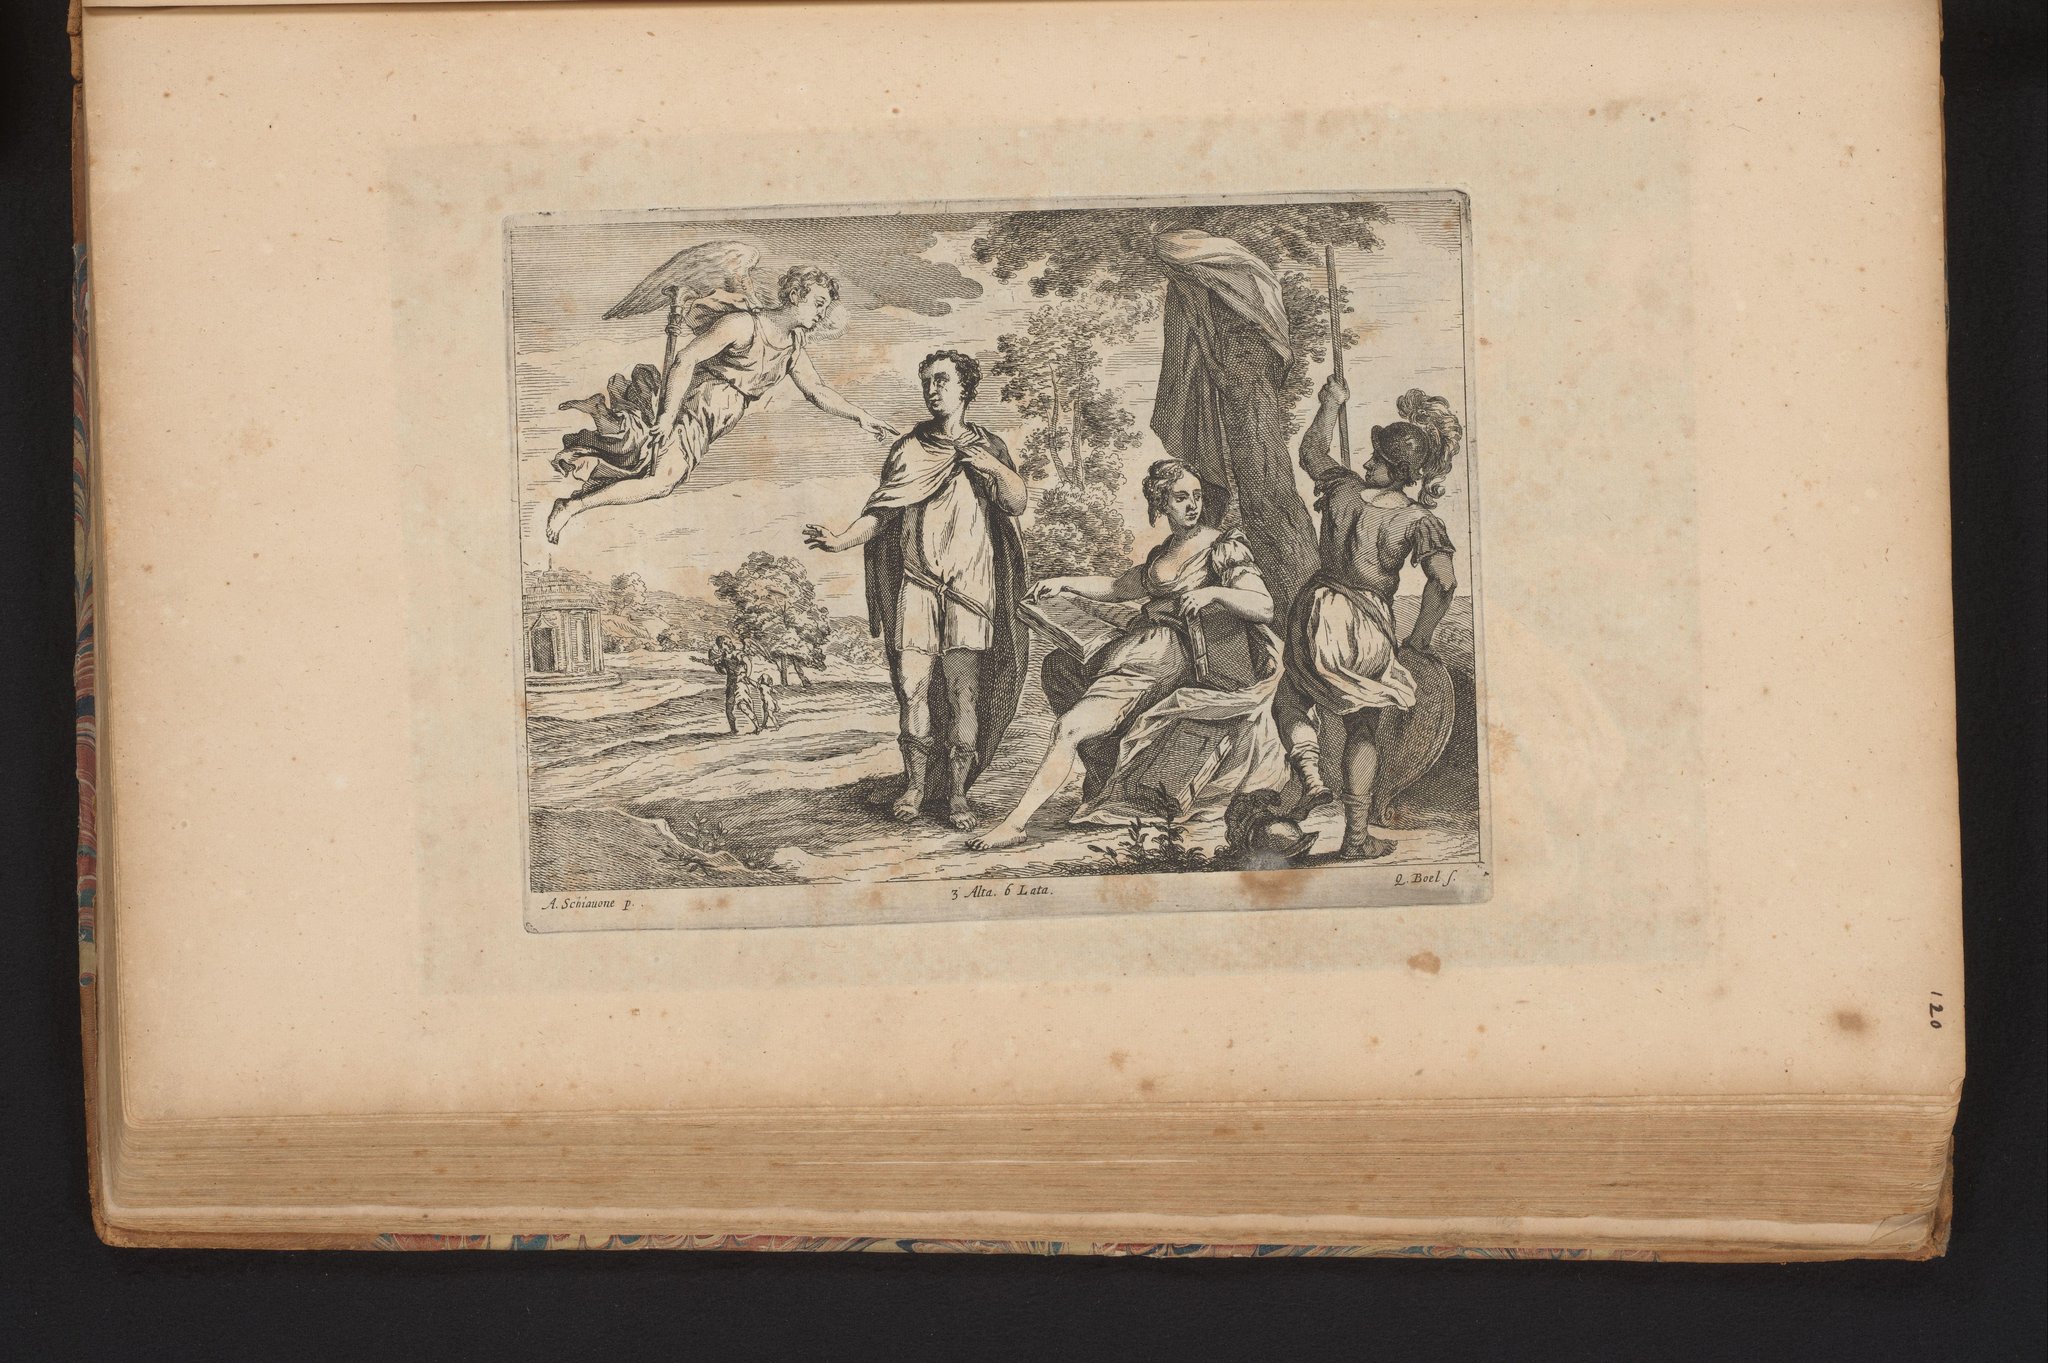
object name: print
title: Aeneas wordt weggeroepen van Dido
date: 1660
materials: paper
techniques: etching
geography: italy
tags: mercury summons aeneas, engaged in building activities, to leave carthage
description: De prent is vervaardigd naar het schilderij van Schiavone dat zich in de collectie van het Kunsthistorisches Museum te Wenen bevindt (inventarisnummer GG_5816). David Teniers heeft waarschijnlijk van alle schilderijen uit de collectie van Leopold Willem van Oostenrijk een olieverfstudie op doek of paneel vervaardigd (zgn. pasticcio), die als voorbeeld voor de prentmakers diende. Het is niet altijd duidelijk of de pasticci door hem zijn gemaakt of door zijn atelier. Niet alle pasticci zijn overgeleverd.